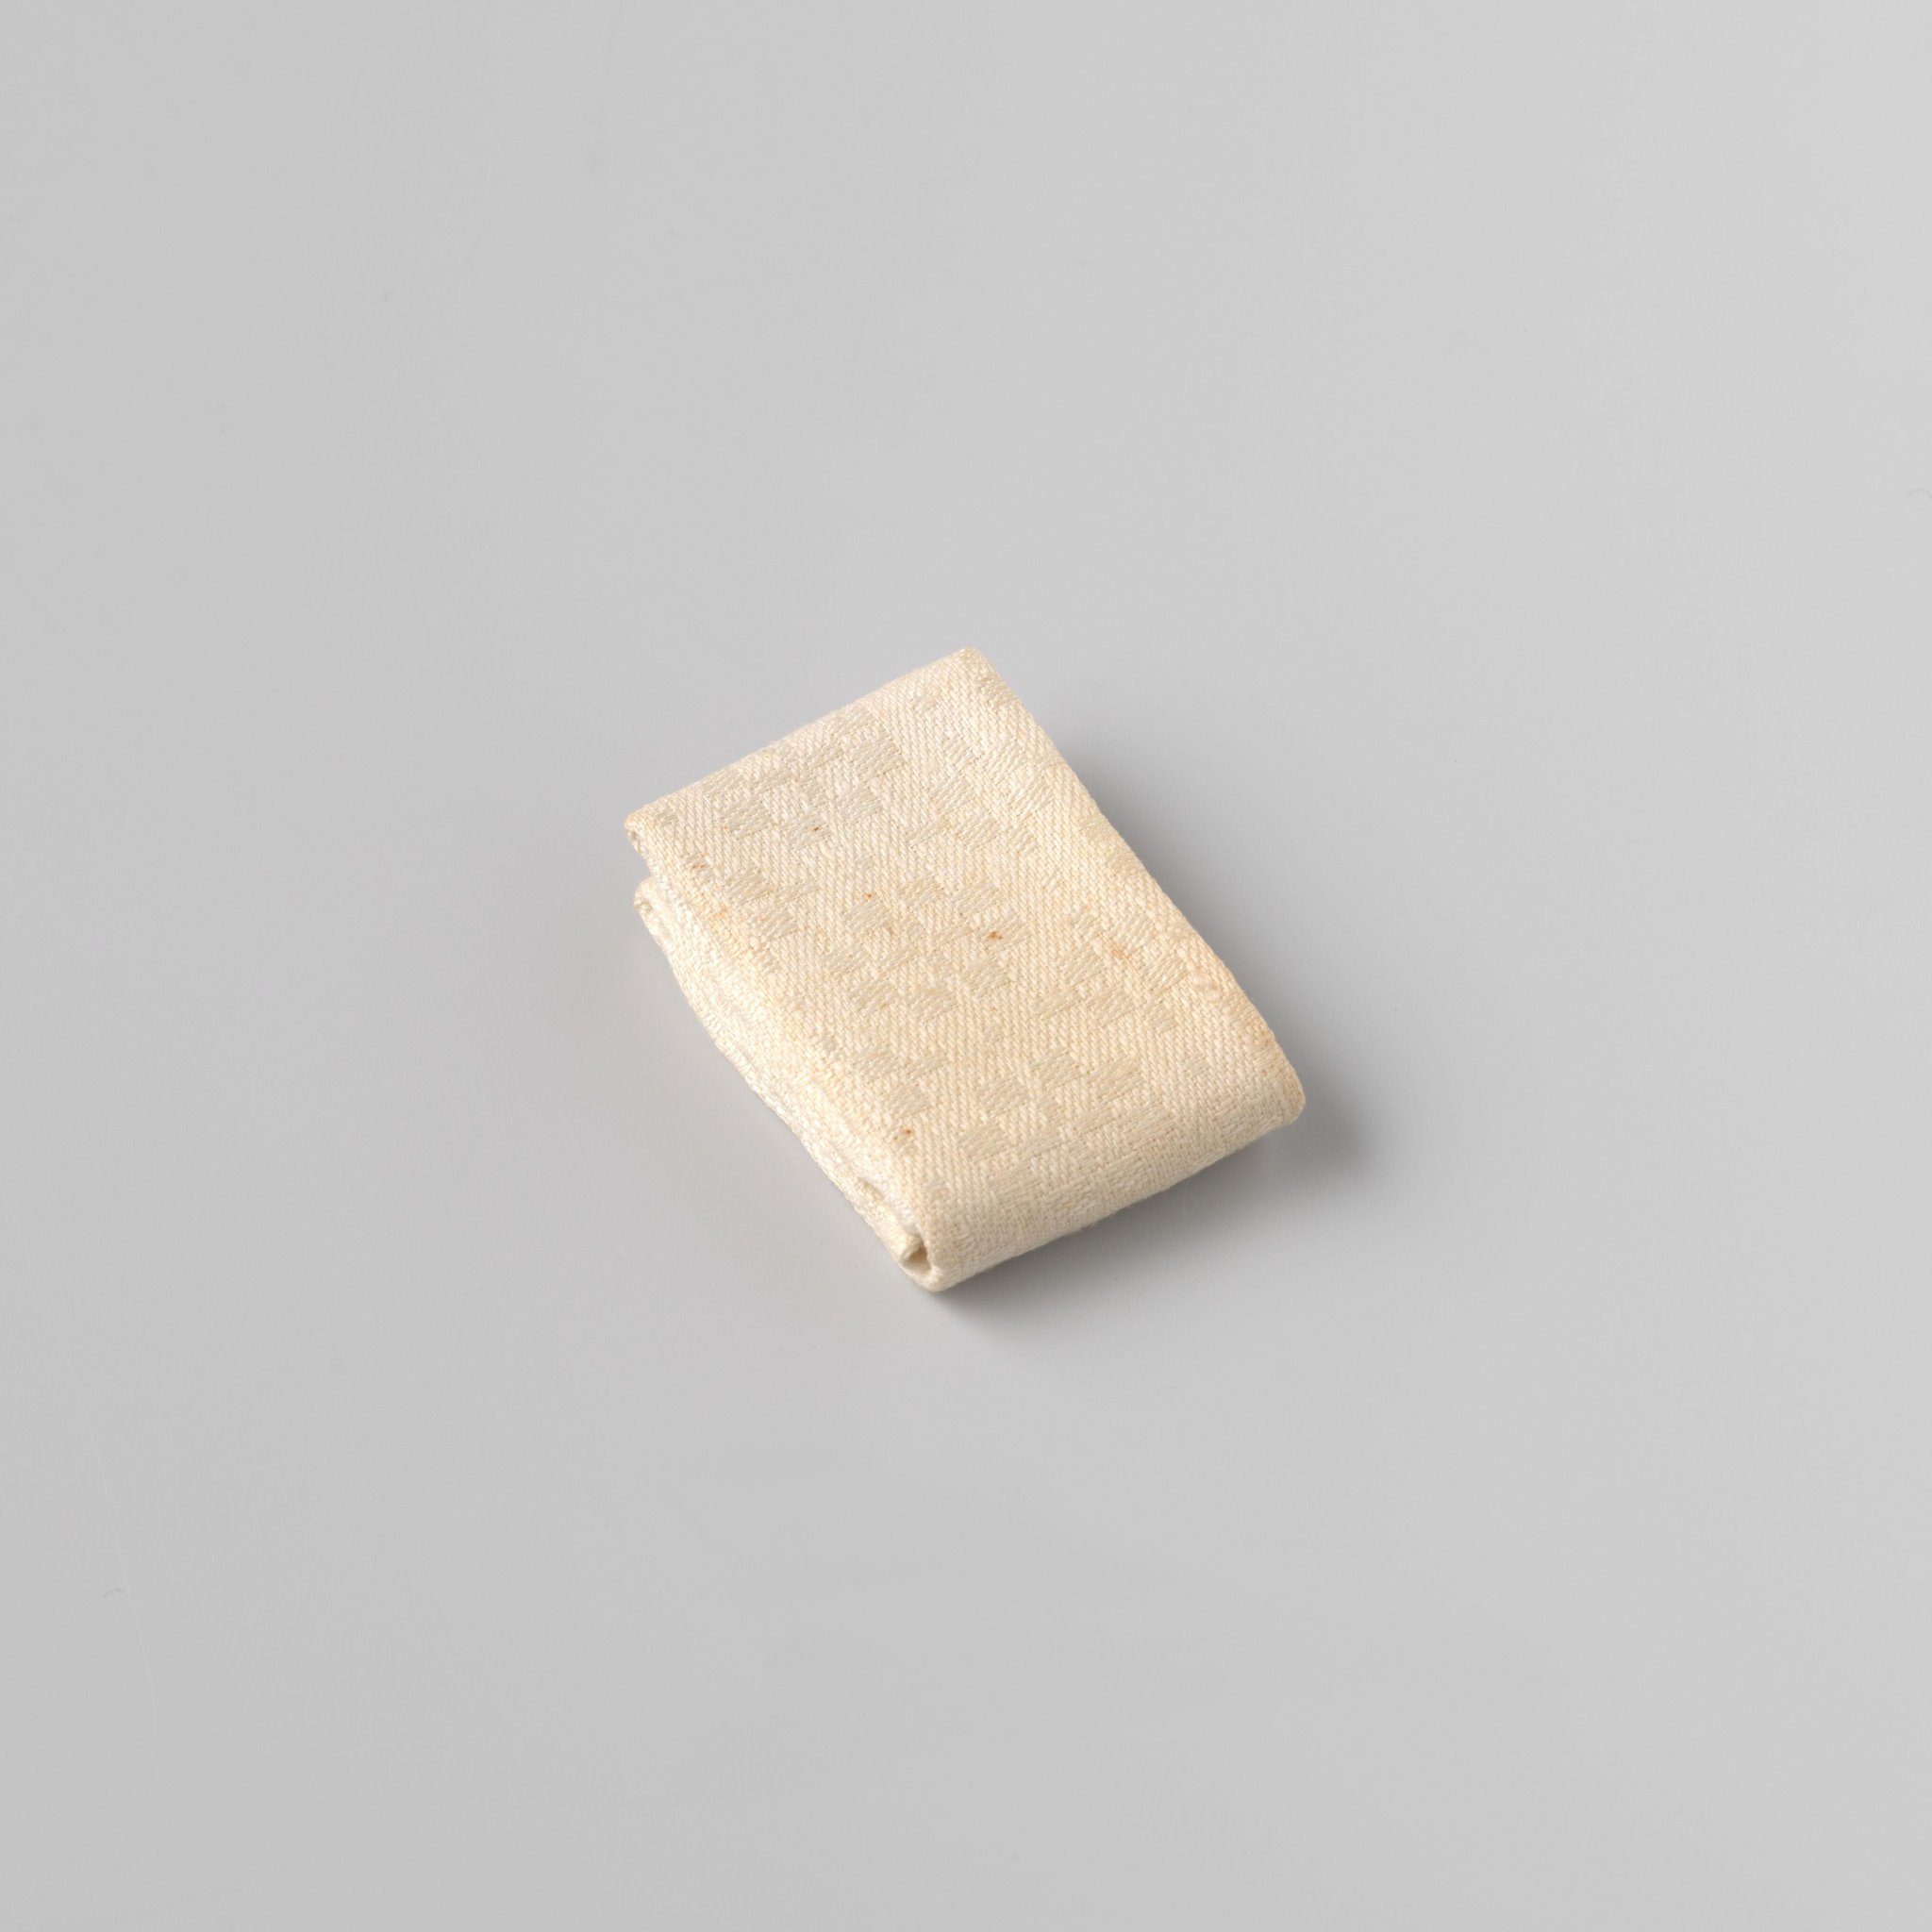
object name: napkin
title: Linnen servet van damastweefsel met pellenpatroon (motief II), aan vier zijden omzoomd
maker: Anonymous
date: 1690-1710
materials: linen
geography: amsterdam